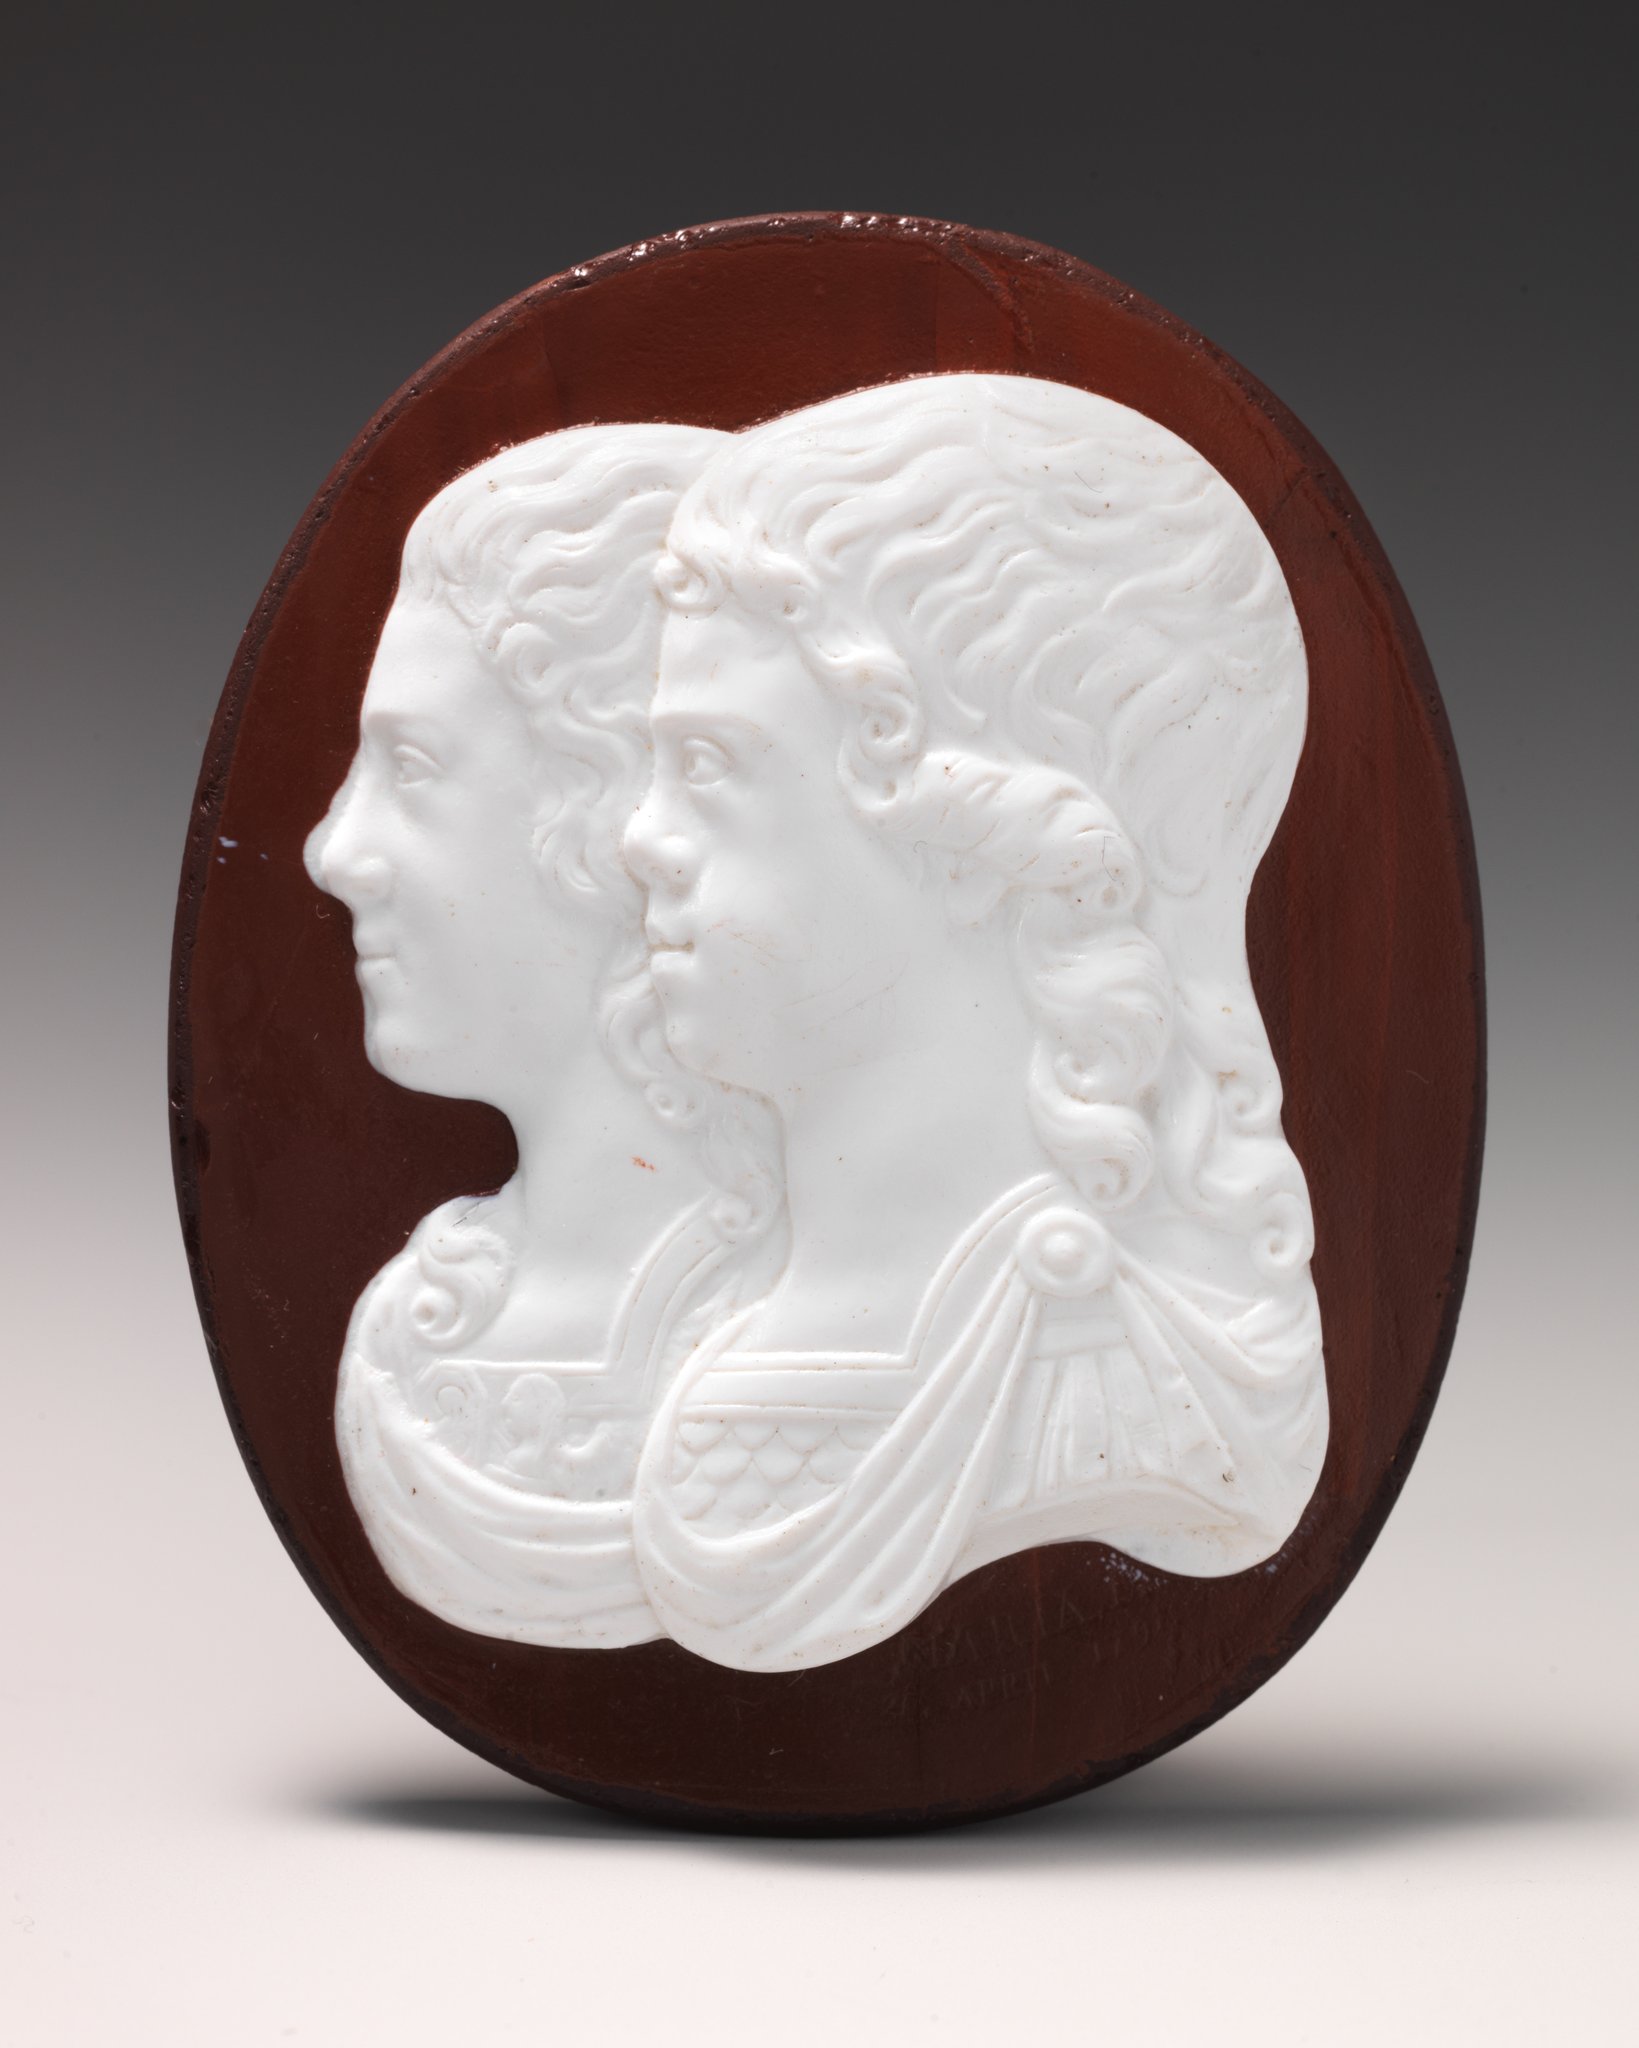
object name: cameo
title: Jugate busts of Czarevitch Paul and Maria Feodorovna of Russia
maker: james tassie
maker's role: artist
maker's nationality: british, scottish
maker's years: 1735-1799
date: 1791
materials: glass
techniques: casting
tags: men,profiles,women